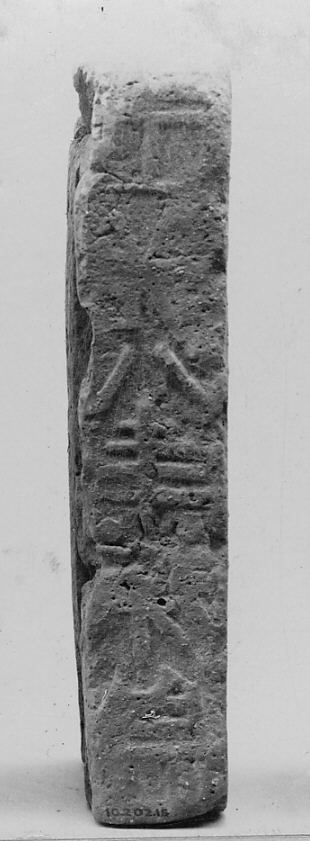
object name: tile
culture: chinese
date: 221 BCE-220 CE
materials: earthenware